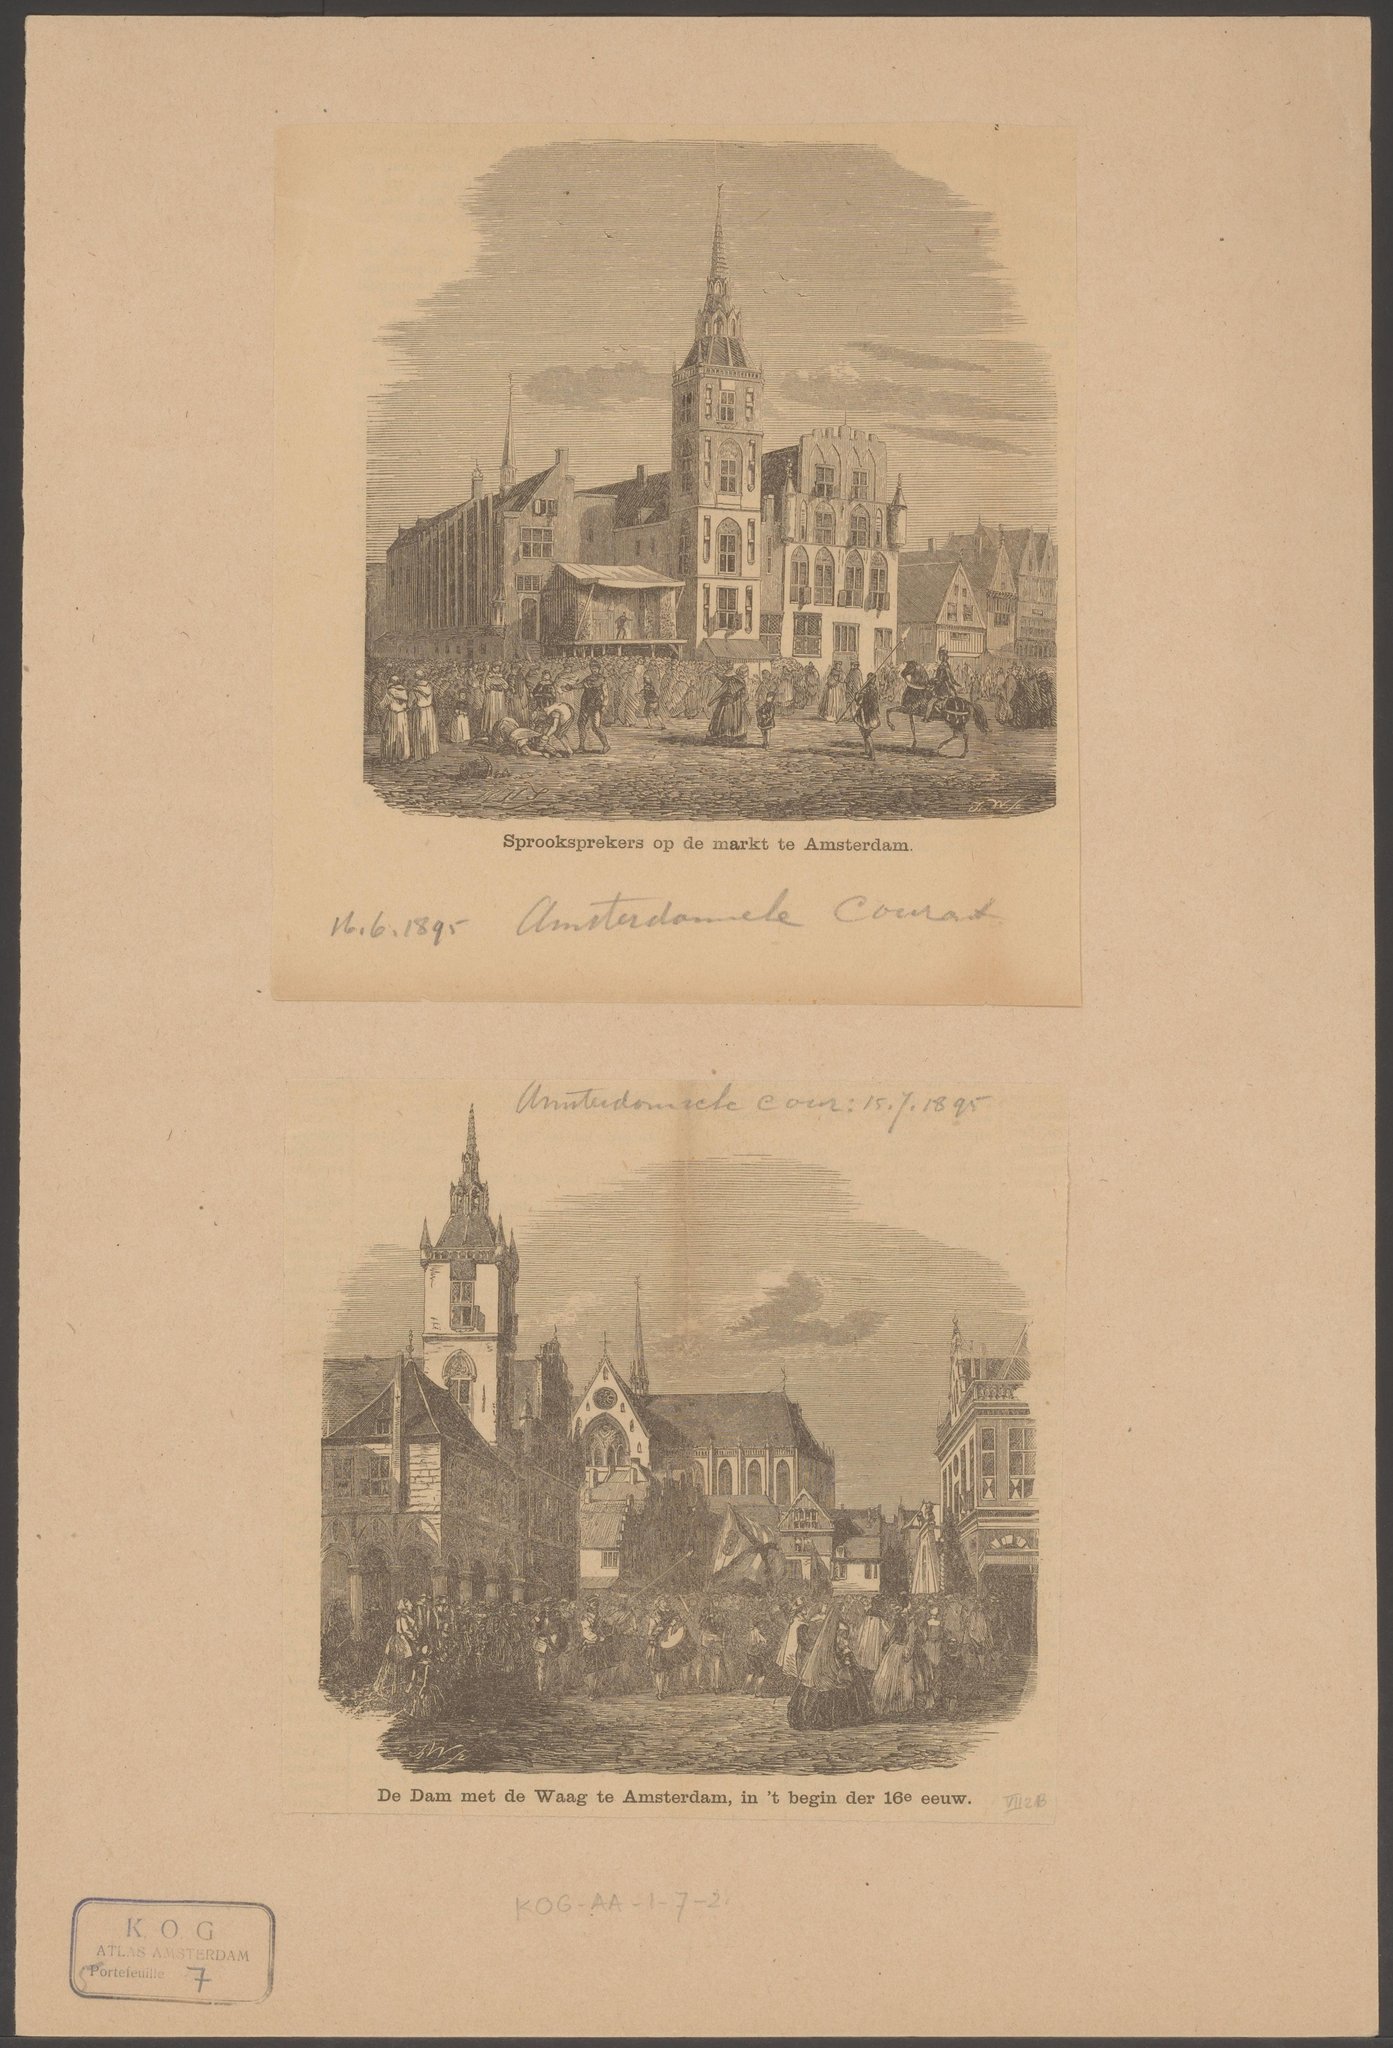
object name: print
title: Gezichten op de Dam in de 16e eeuw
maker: Anonymous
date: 1895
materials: paper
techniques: letterpress printing, engraving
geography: amsterdam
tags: square, place, circus, etc., city-view in general; 'veduta', weigh-house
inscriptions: inscription: ‘16.6.1895 Amsterdamsche Courant / Amsterdamsche cour: 15.7.1895’, collector's mark: ‘7’ Lugt 1641b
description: Prenten uit: De Amsterdamsche Courant (1895), 16 juni 1895 en 15 juli 1895.